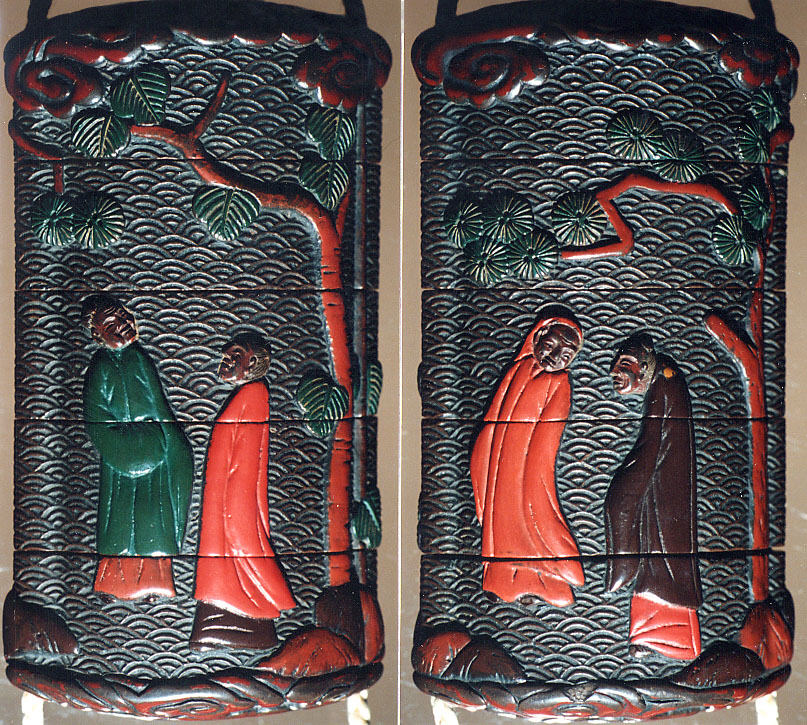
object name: inrō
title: Case (Inrō) with Design of Chinese Persons Beneath Pine Trees and Clouds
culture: japanese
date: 1801-1900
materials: lacquer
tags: men,trees